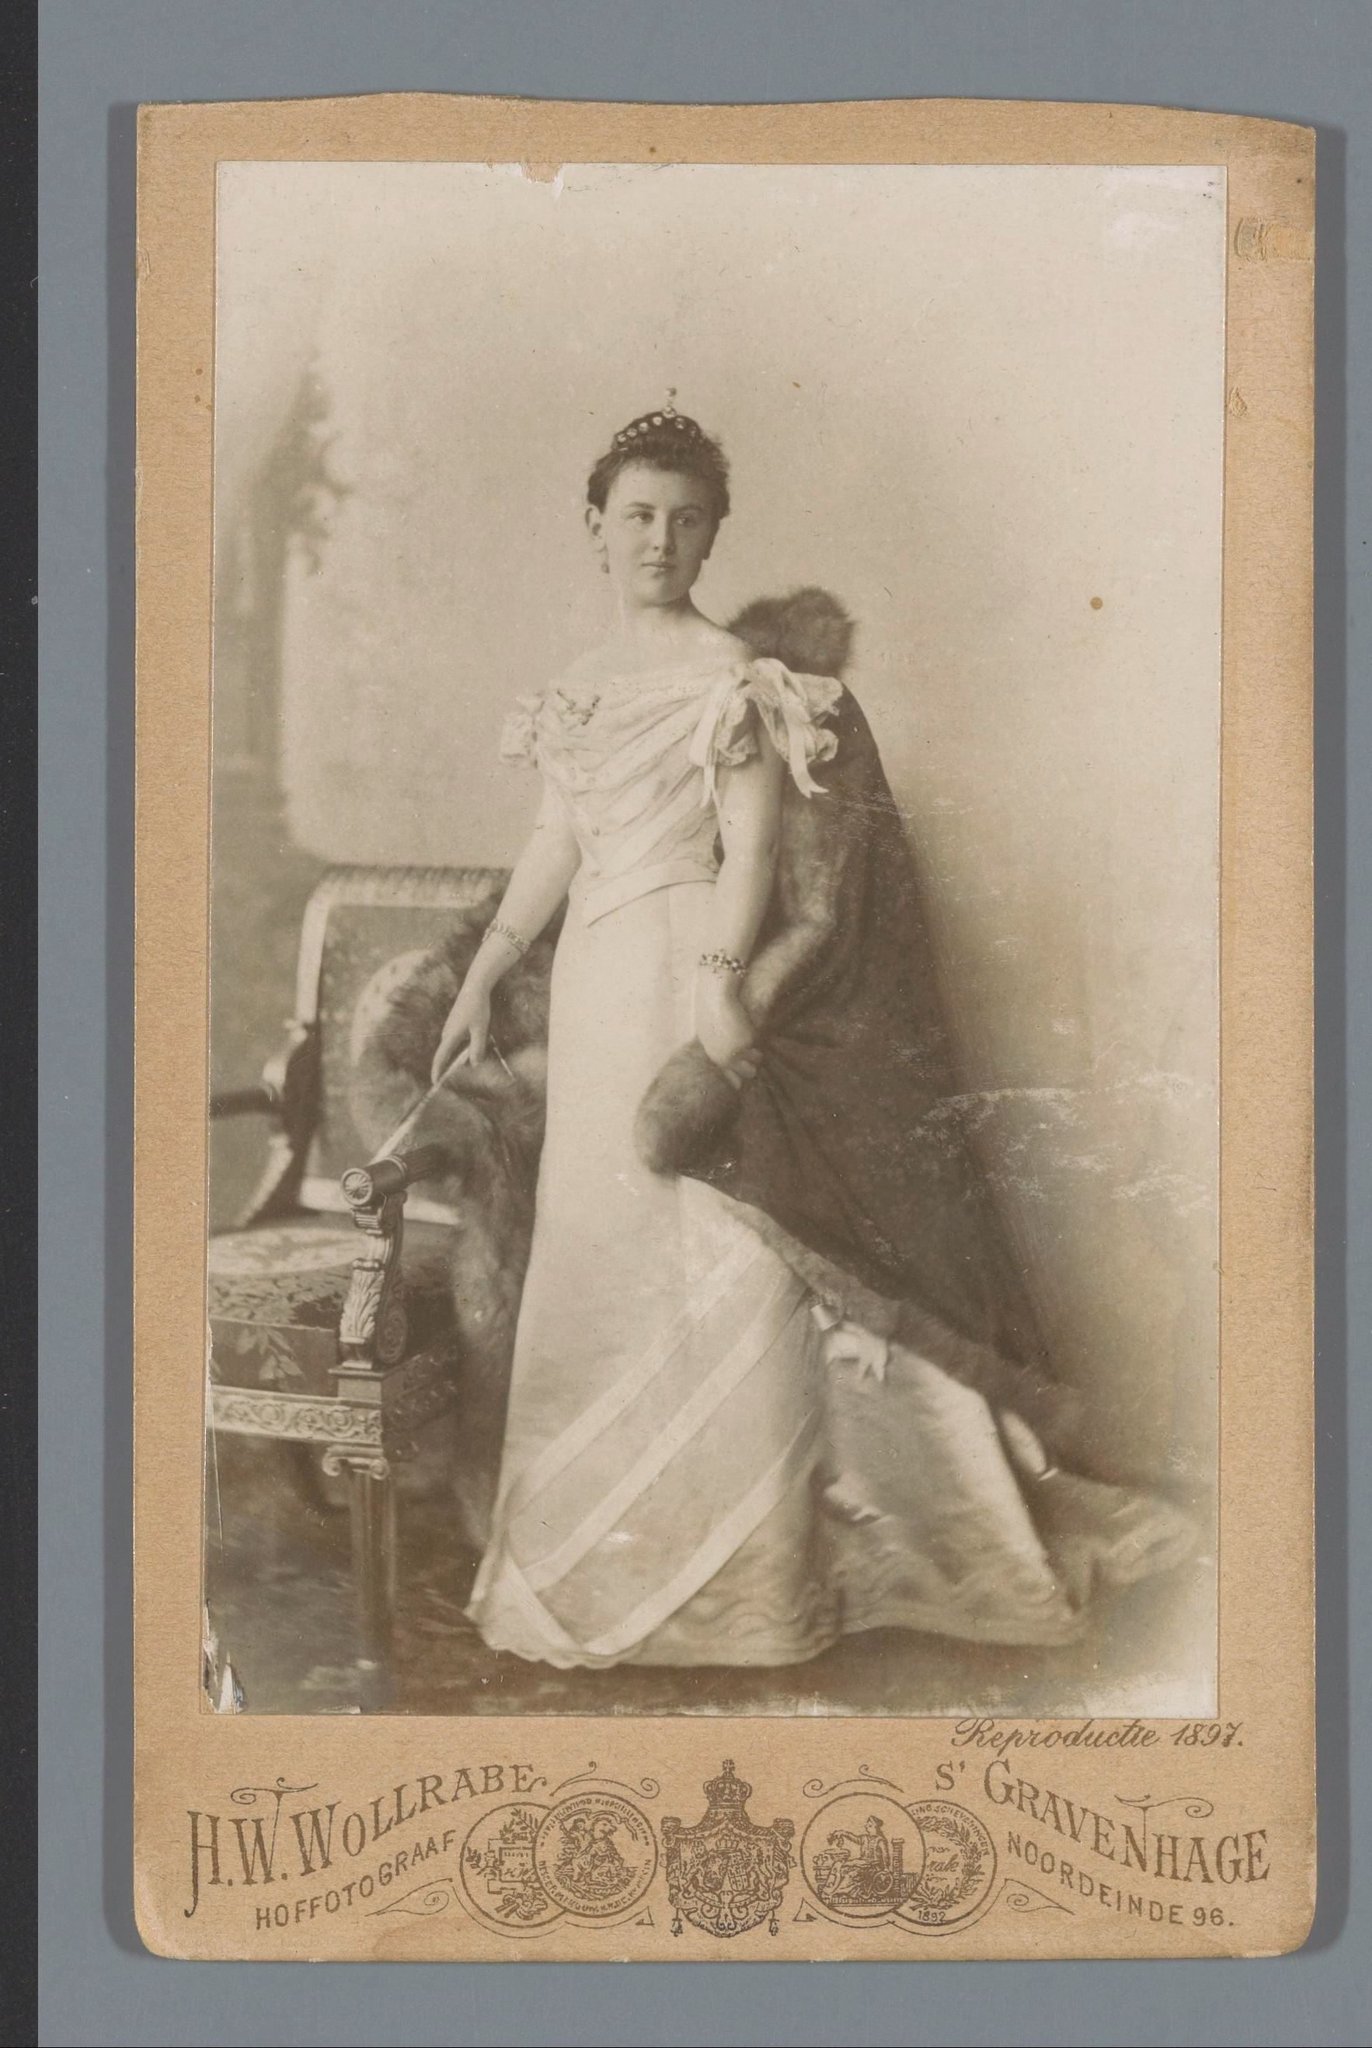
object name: carte de visite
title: Portret van prinses Wilhelmina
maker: heinrich wilhelm wollrabe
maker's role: fotograaf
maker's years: 1843-1928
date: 1897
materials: cardboard, photographic support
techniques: collodion silver print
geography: the hague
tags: the hague, print maker, wilhelmina of the netherlands, crown princess, historical persons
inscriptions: inscription: ‘1897’, inscription: ‘Reproductie 1897./ s'GRAVENHAVE/ NOORDEINDE 96.’, number: ‘25’